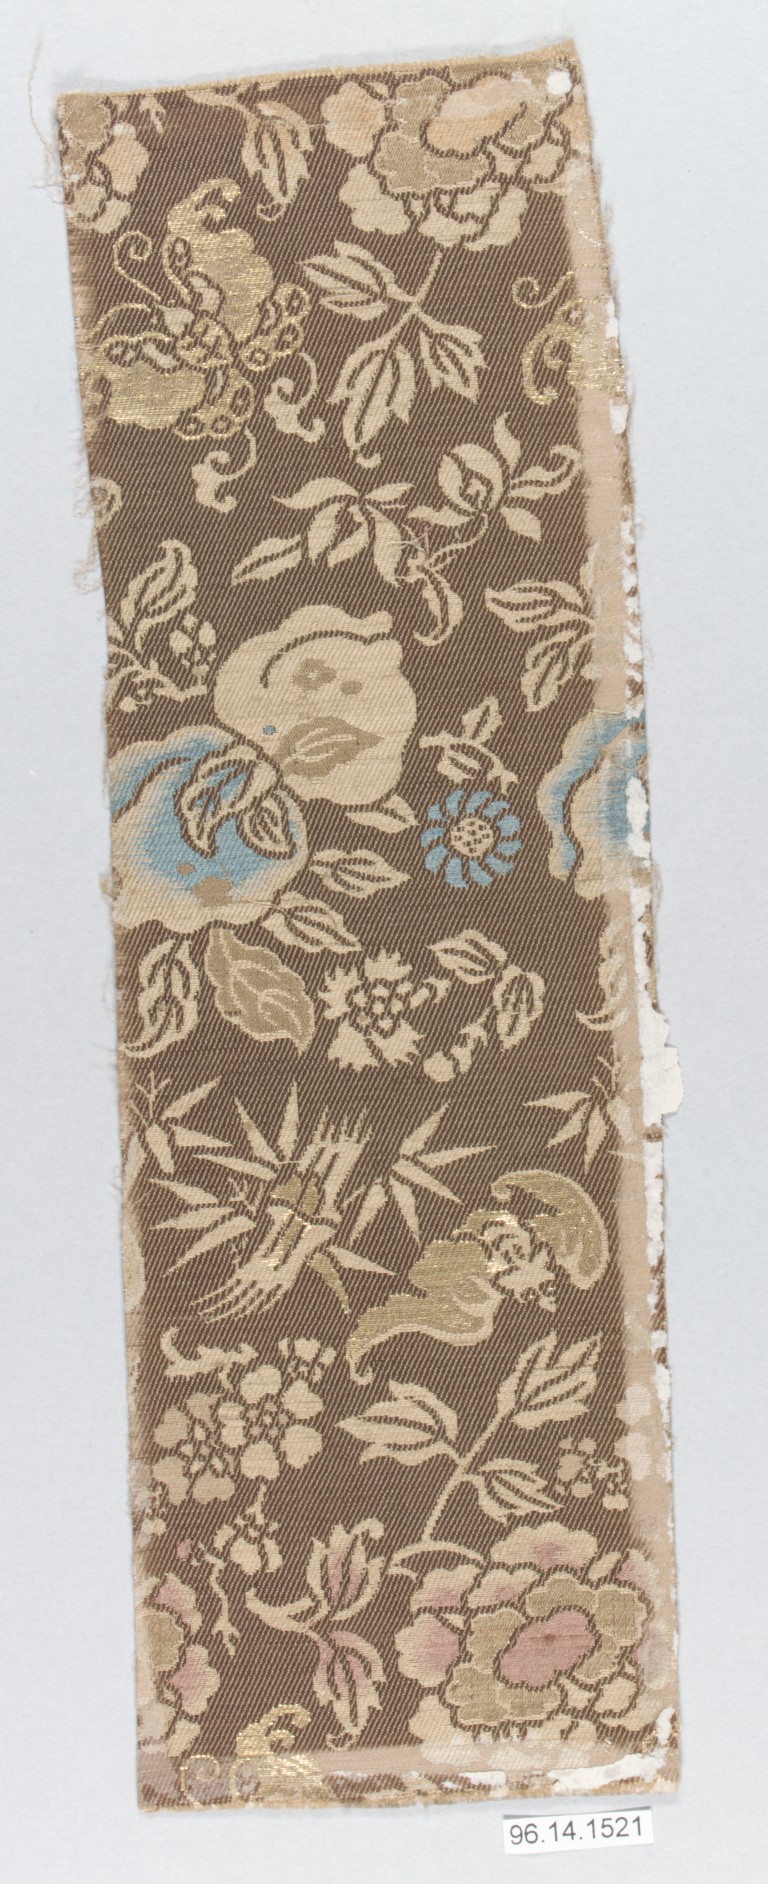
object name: piece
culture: japanese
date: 1801-1833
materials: silk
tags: leaves